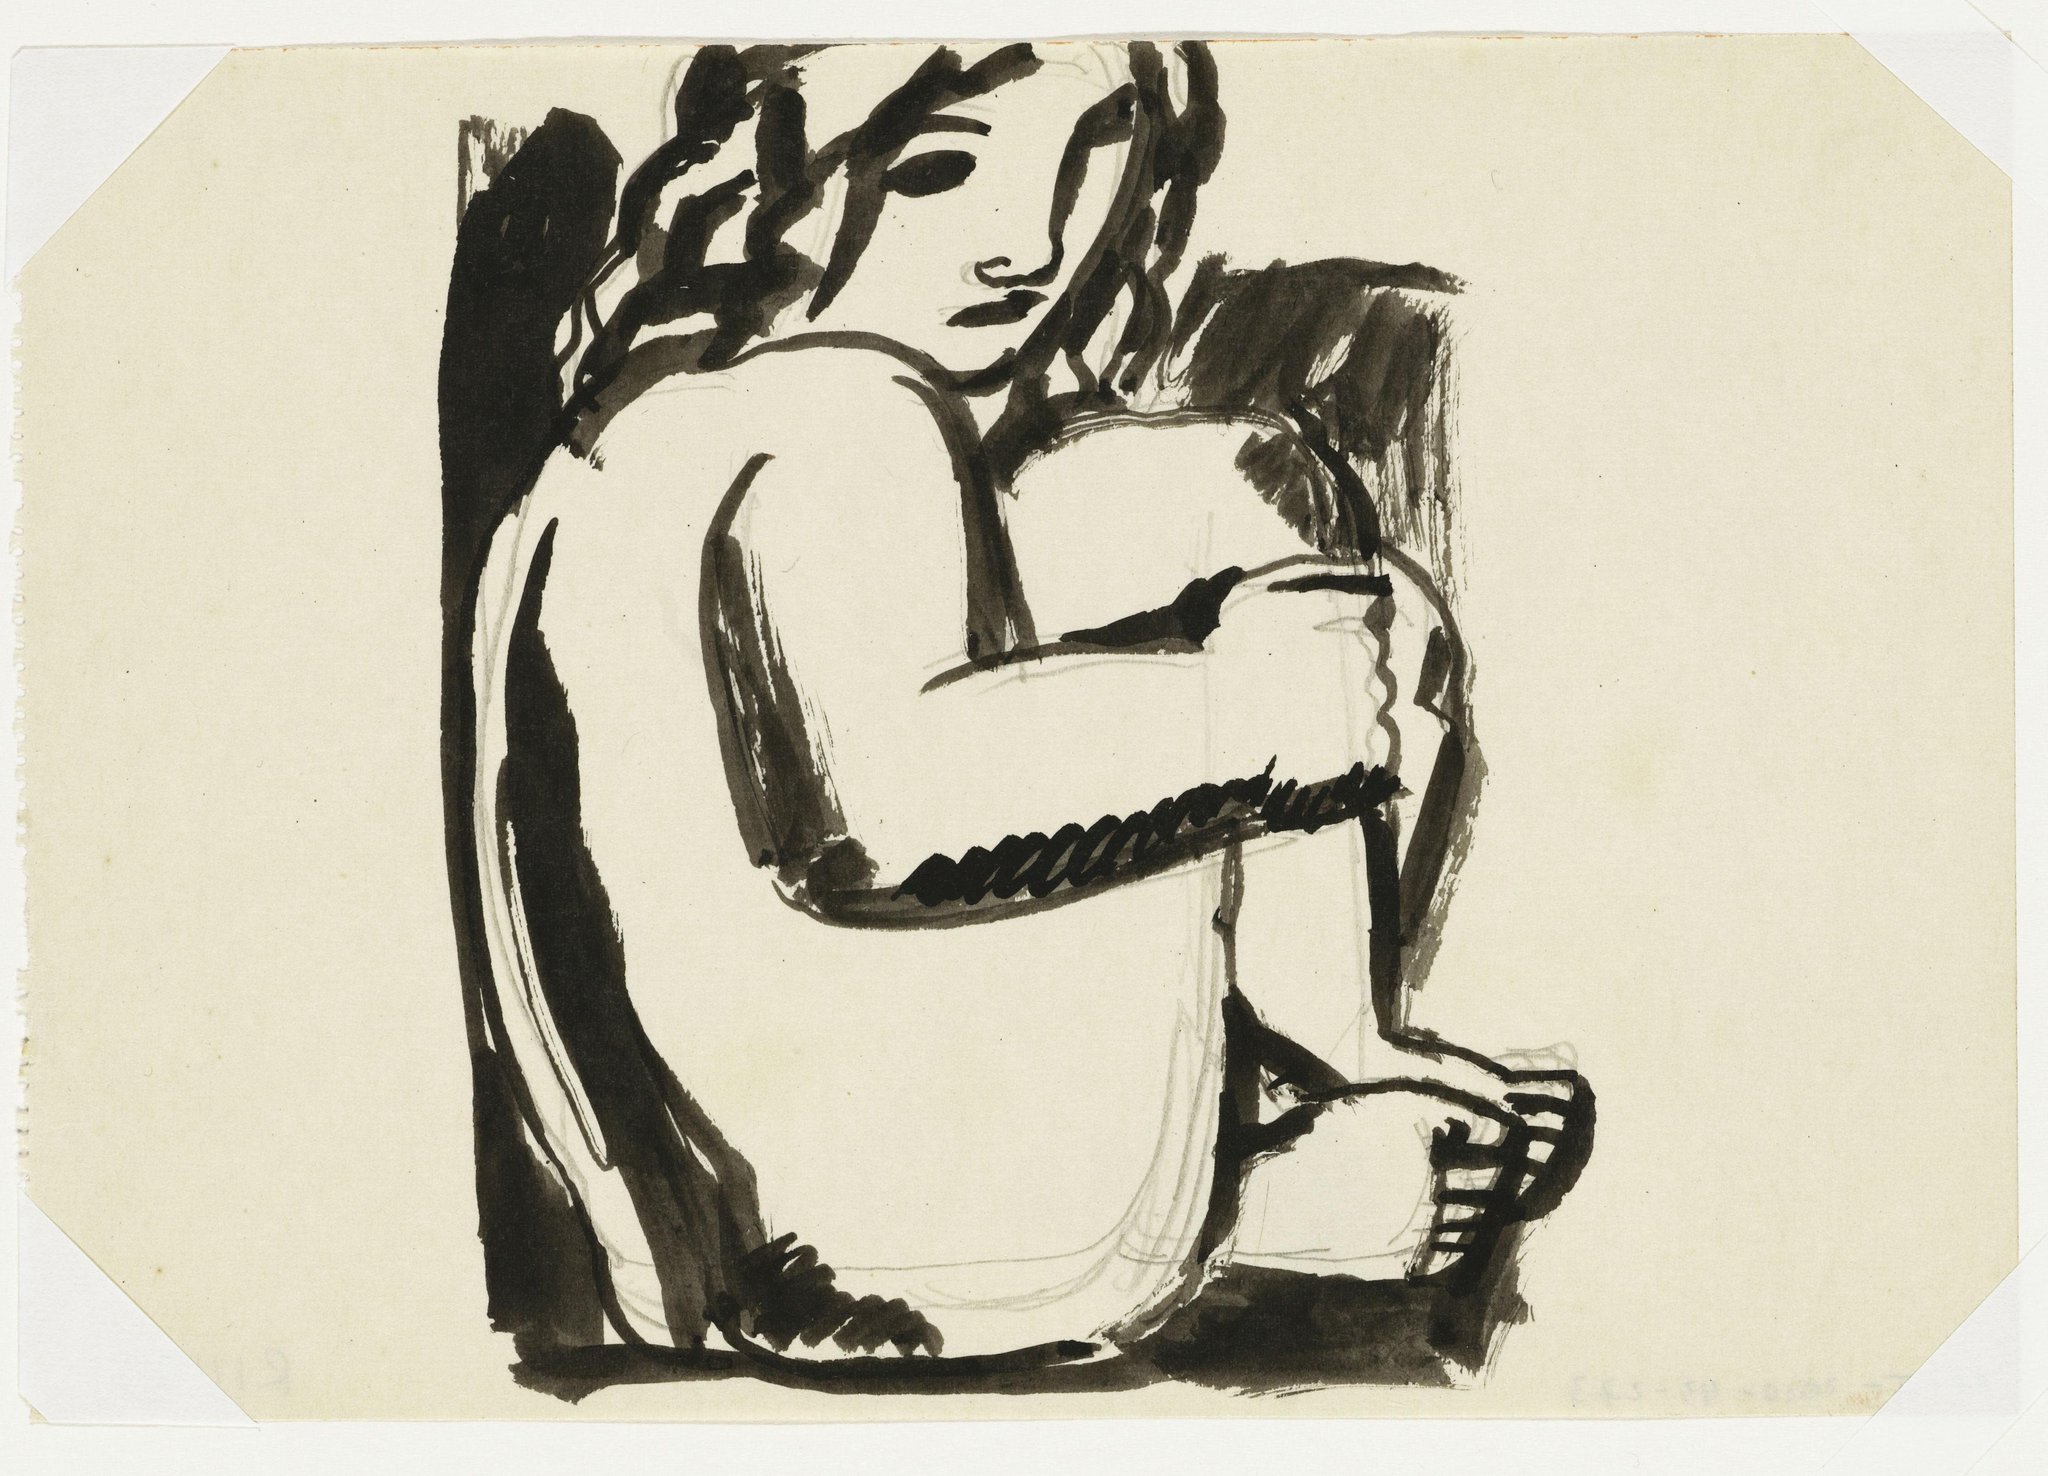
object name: drawing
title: Zonder titel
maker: leo gestel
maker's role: draughtsman, print maker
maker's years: 1881-1941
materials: ink, paper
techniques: brush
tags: sitting figure - aa - female human figure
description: Naakte zittende vrouw met opgetrokken knieën, de amandelvormige ogen zwart opgevuld.